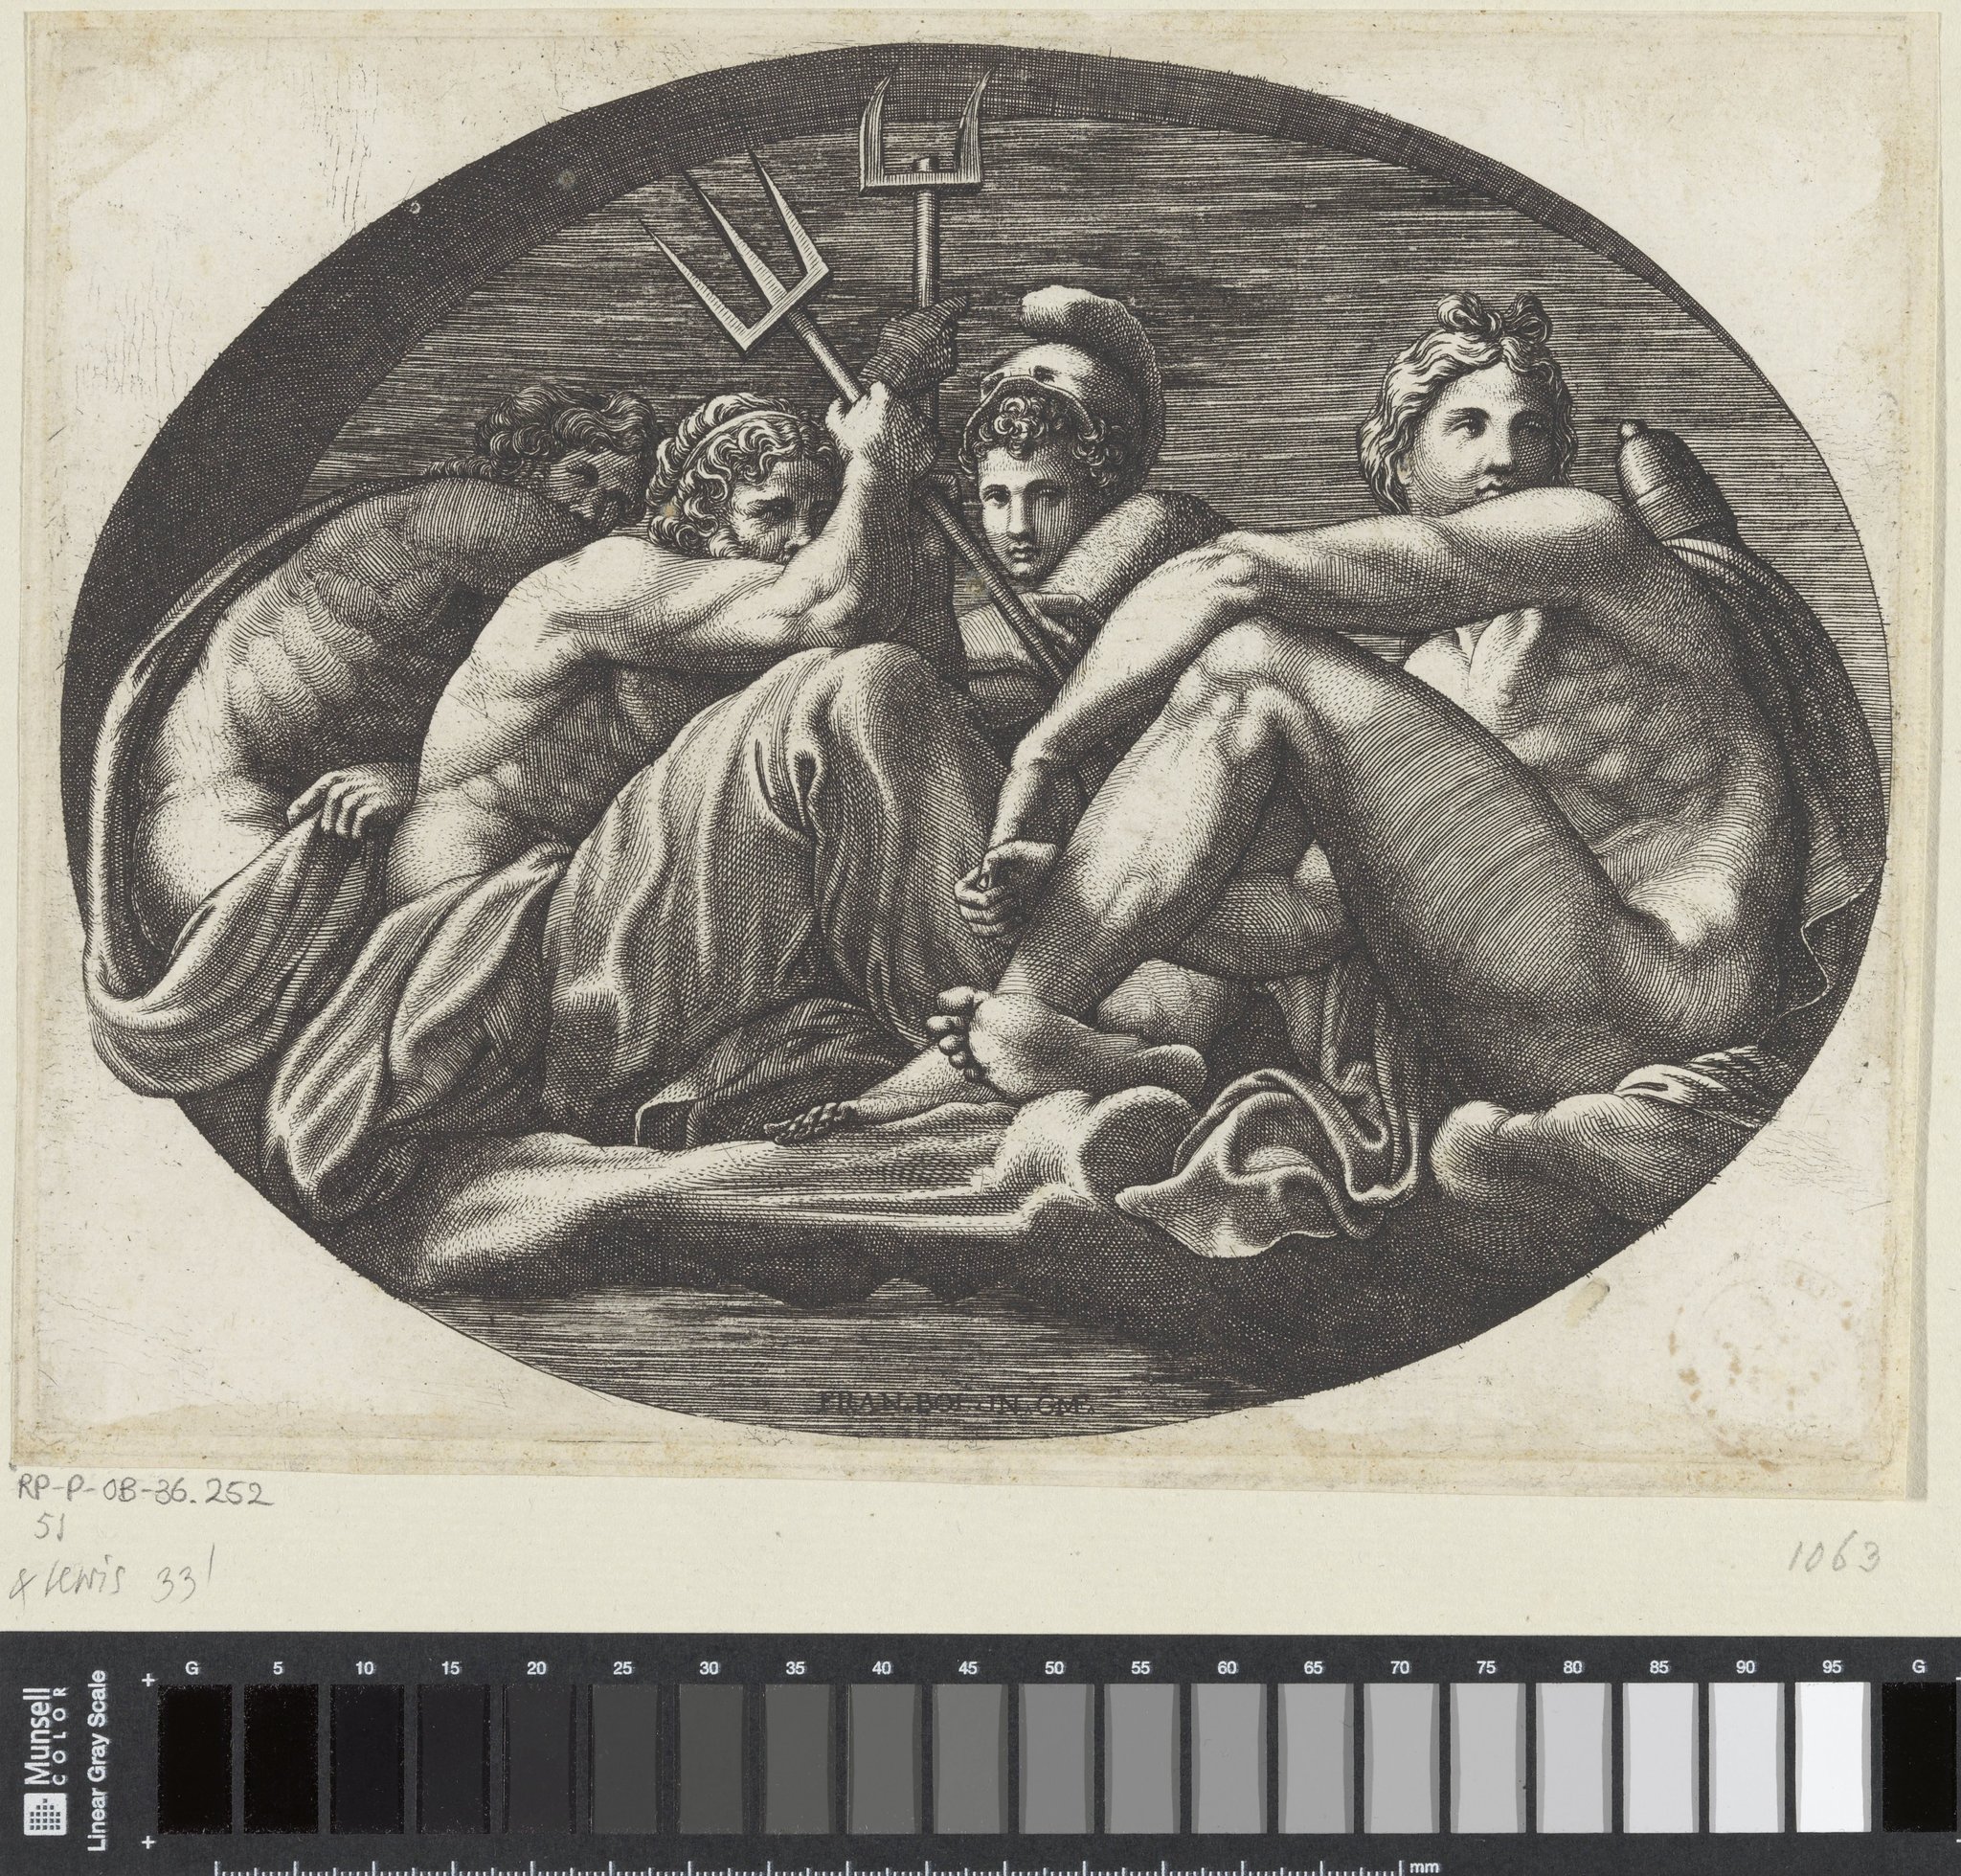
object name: print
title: Apollo, Neptunus, Pluto en Minerva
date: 1541-1582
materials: paper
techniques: engraving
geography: italy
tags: (story of) neptune (poseidon), (story of) apollo (phoebus), (story of) minerva (pallas, athena), (story of) pluto (hades), dis pater, orcus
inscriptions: collector's mark: Lugt 240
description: Prent uit een reeks van vier prenten naar plafondschilderingen in de Galerie d'Ulysse te Fontainebleau, door Francesco Primaticcio.